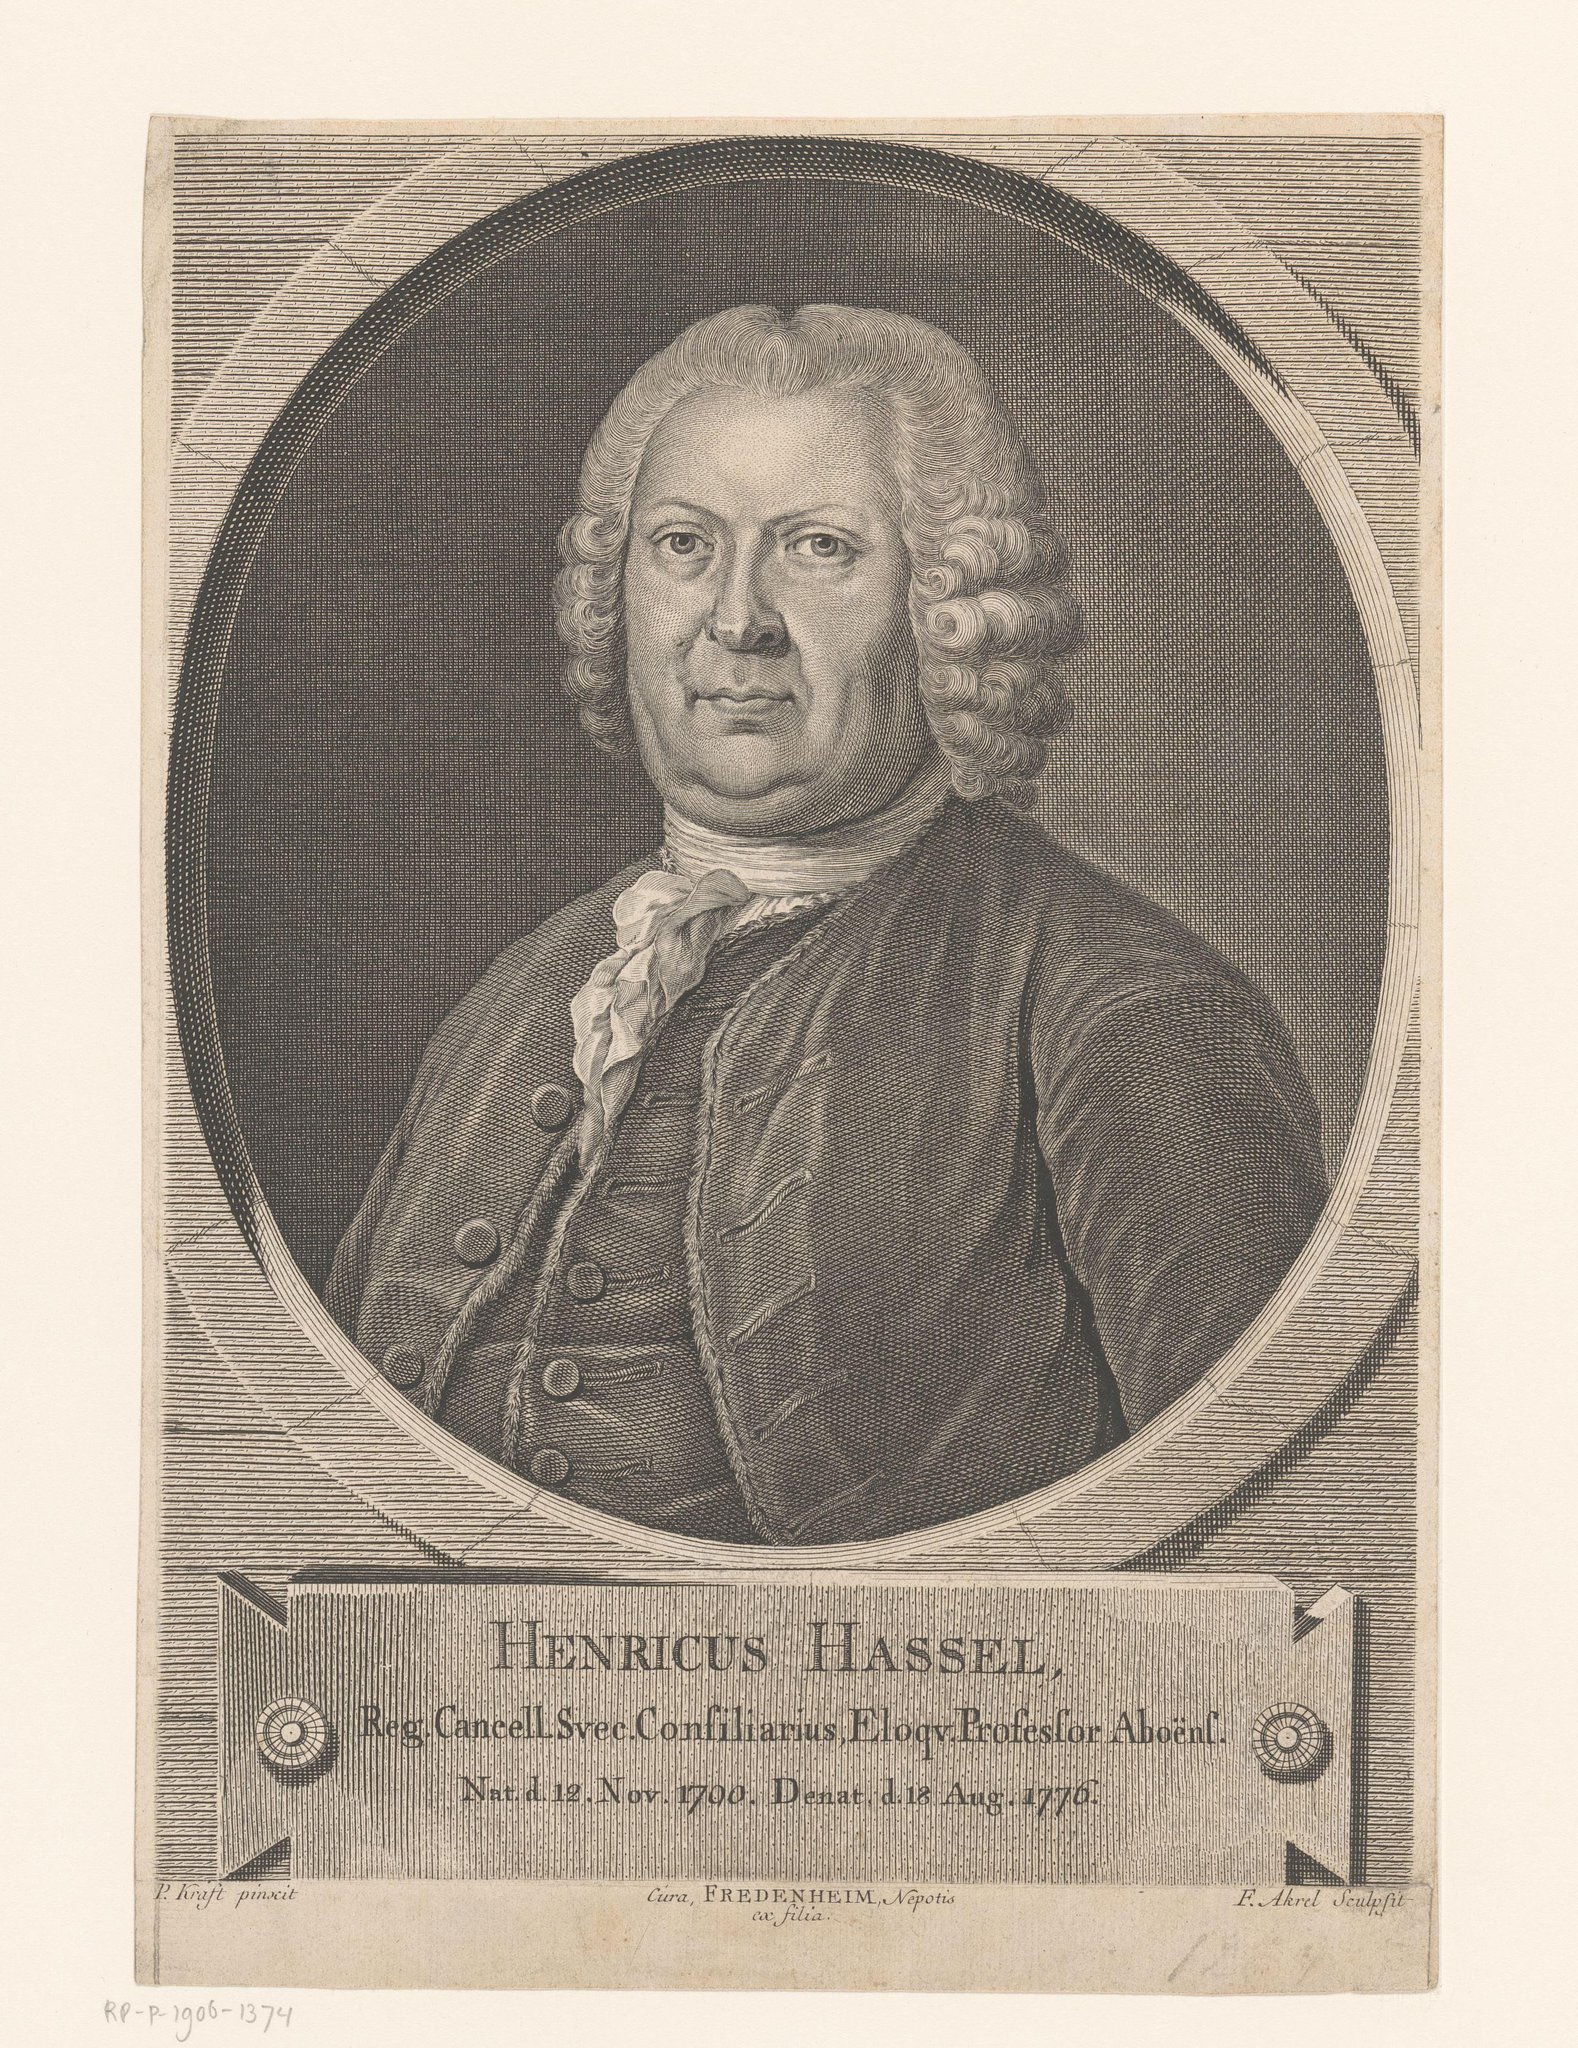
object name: print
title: Henricus Hassel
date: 1776-1804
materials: paper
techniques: engraving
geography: sweden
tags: professor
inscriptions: collector's mark: Lugt 2228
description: Portret van Henricus Hassel, ten halven lijve, in ovaal, driekwart naar links.